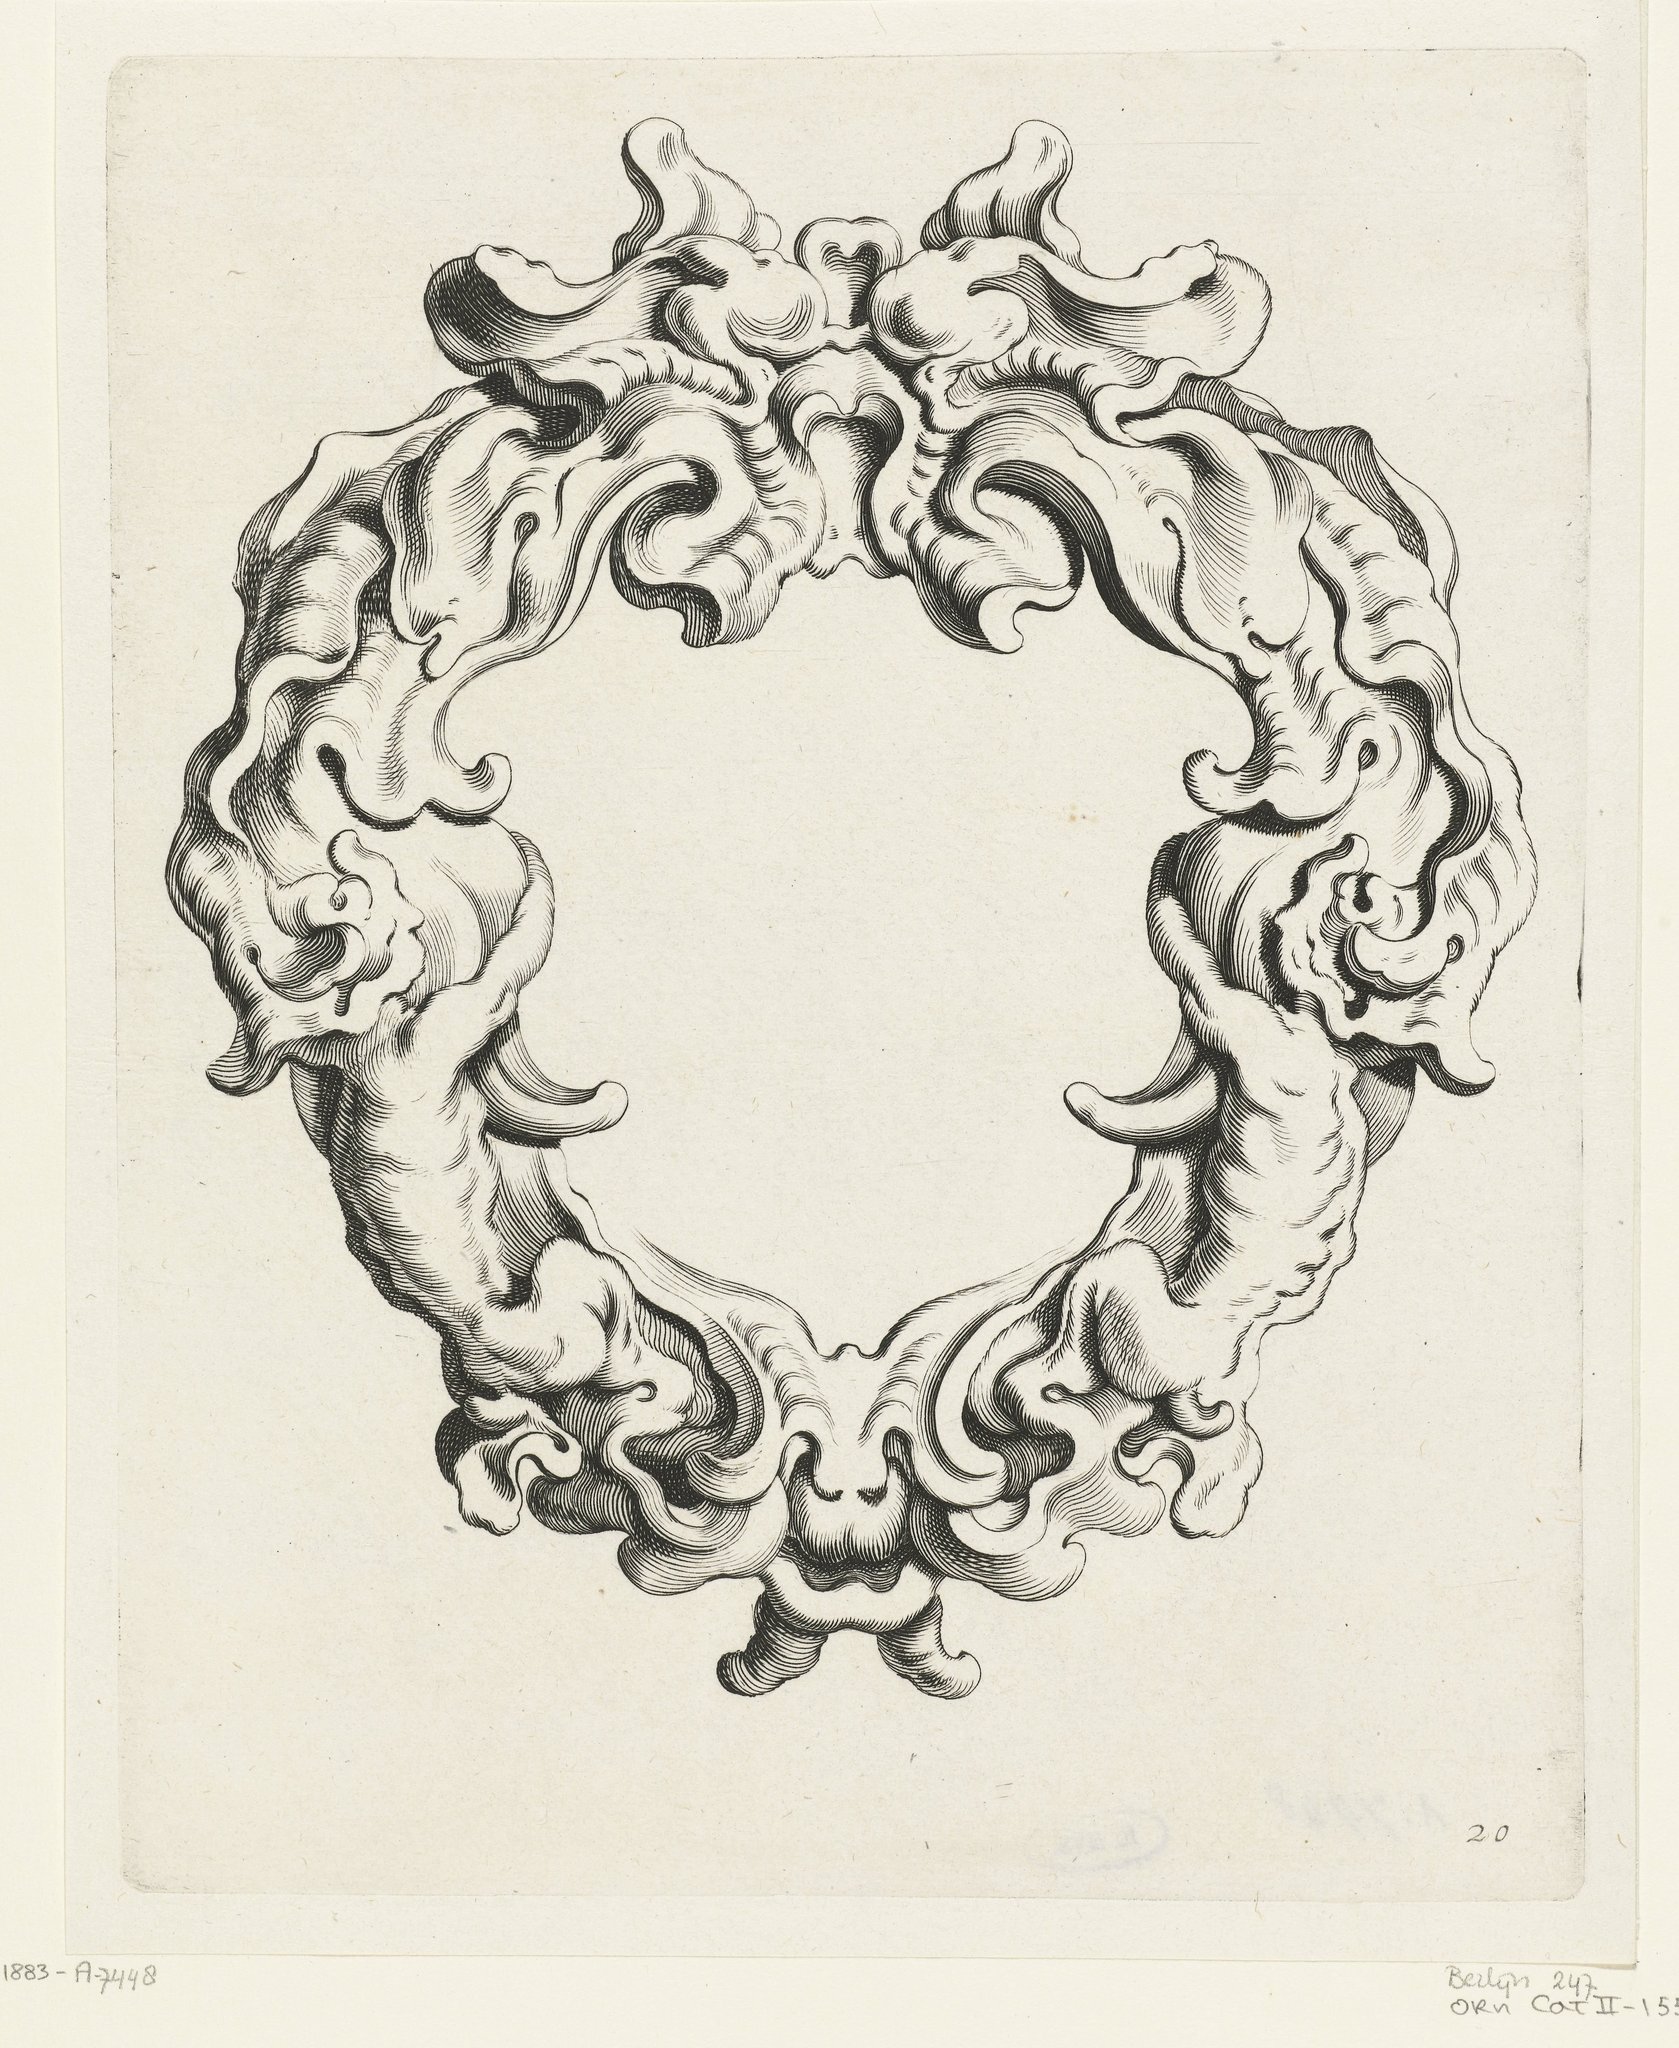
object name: print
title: Cartouche met kwabornament met twee saters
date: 1640-1655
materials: paper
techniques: engraving, etching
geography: amsterdam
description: Bovenaan een masker. Twee saters houden zich vast aan de zijkanten van de cartouche, hun hoofden en hoeven zijn verborgen in de ornamentatie.